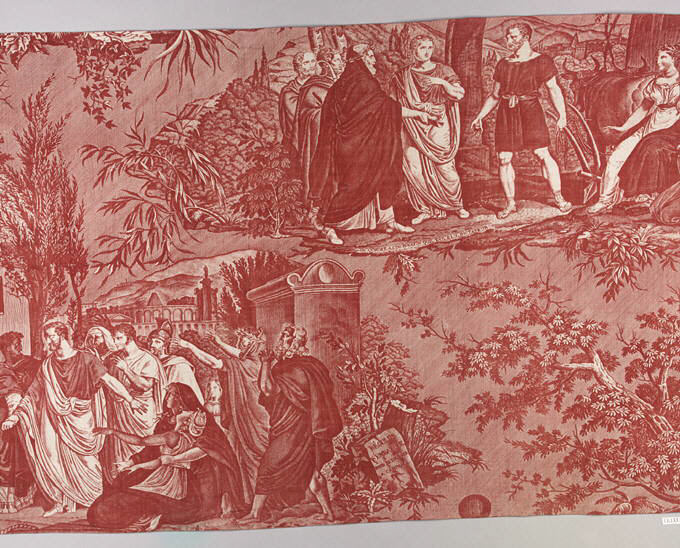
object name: furnishing textile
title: Scenes from Roman history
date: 1815-1825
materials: cotton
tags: animals,buildings,men,women,trees